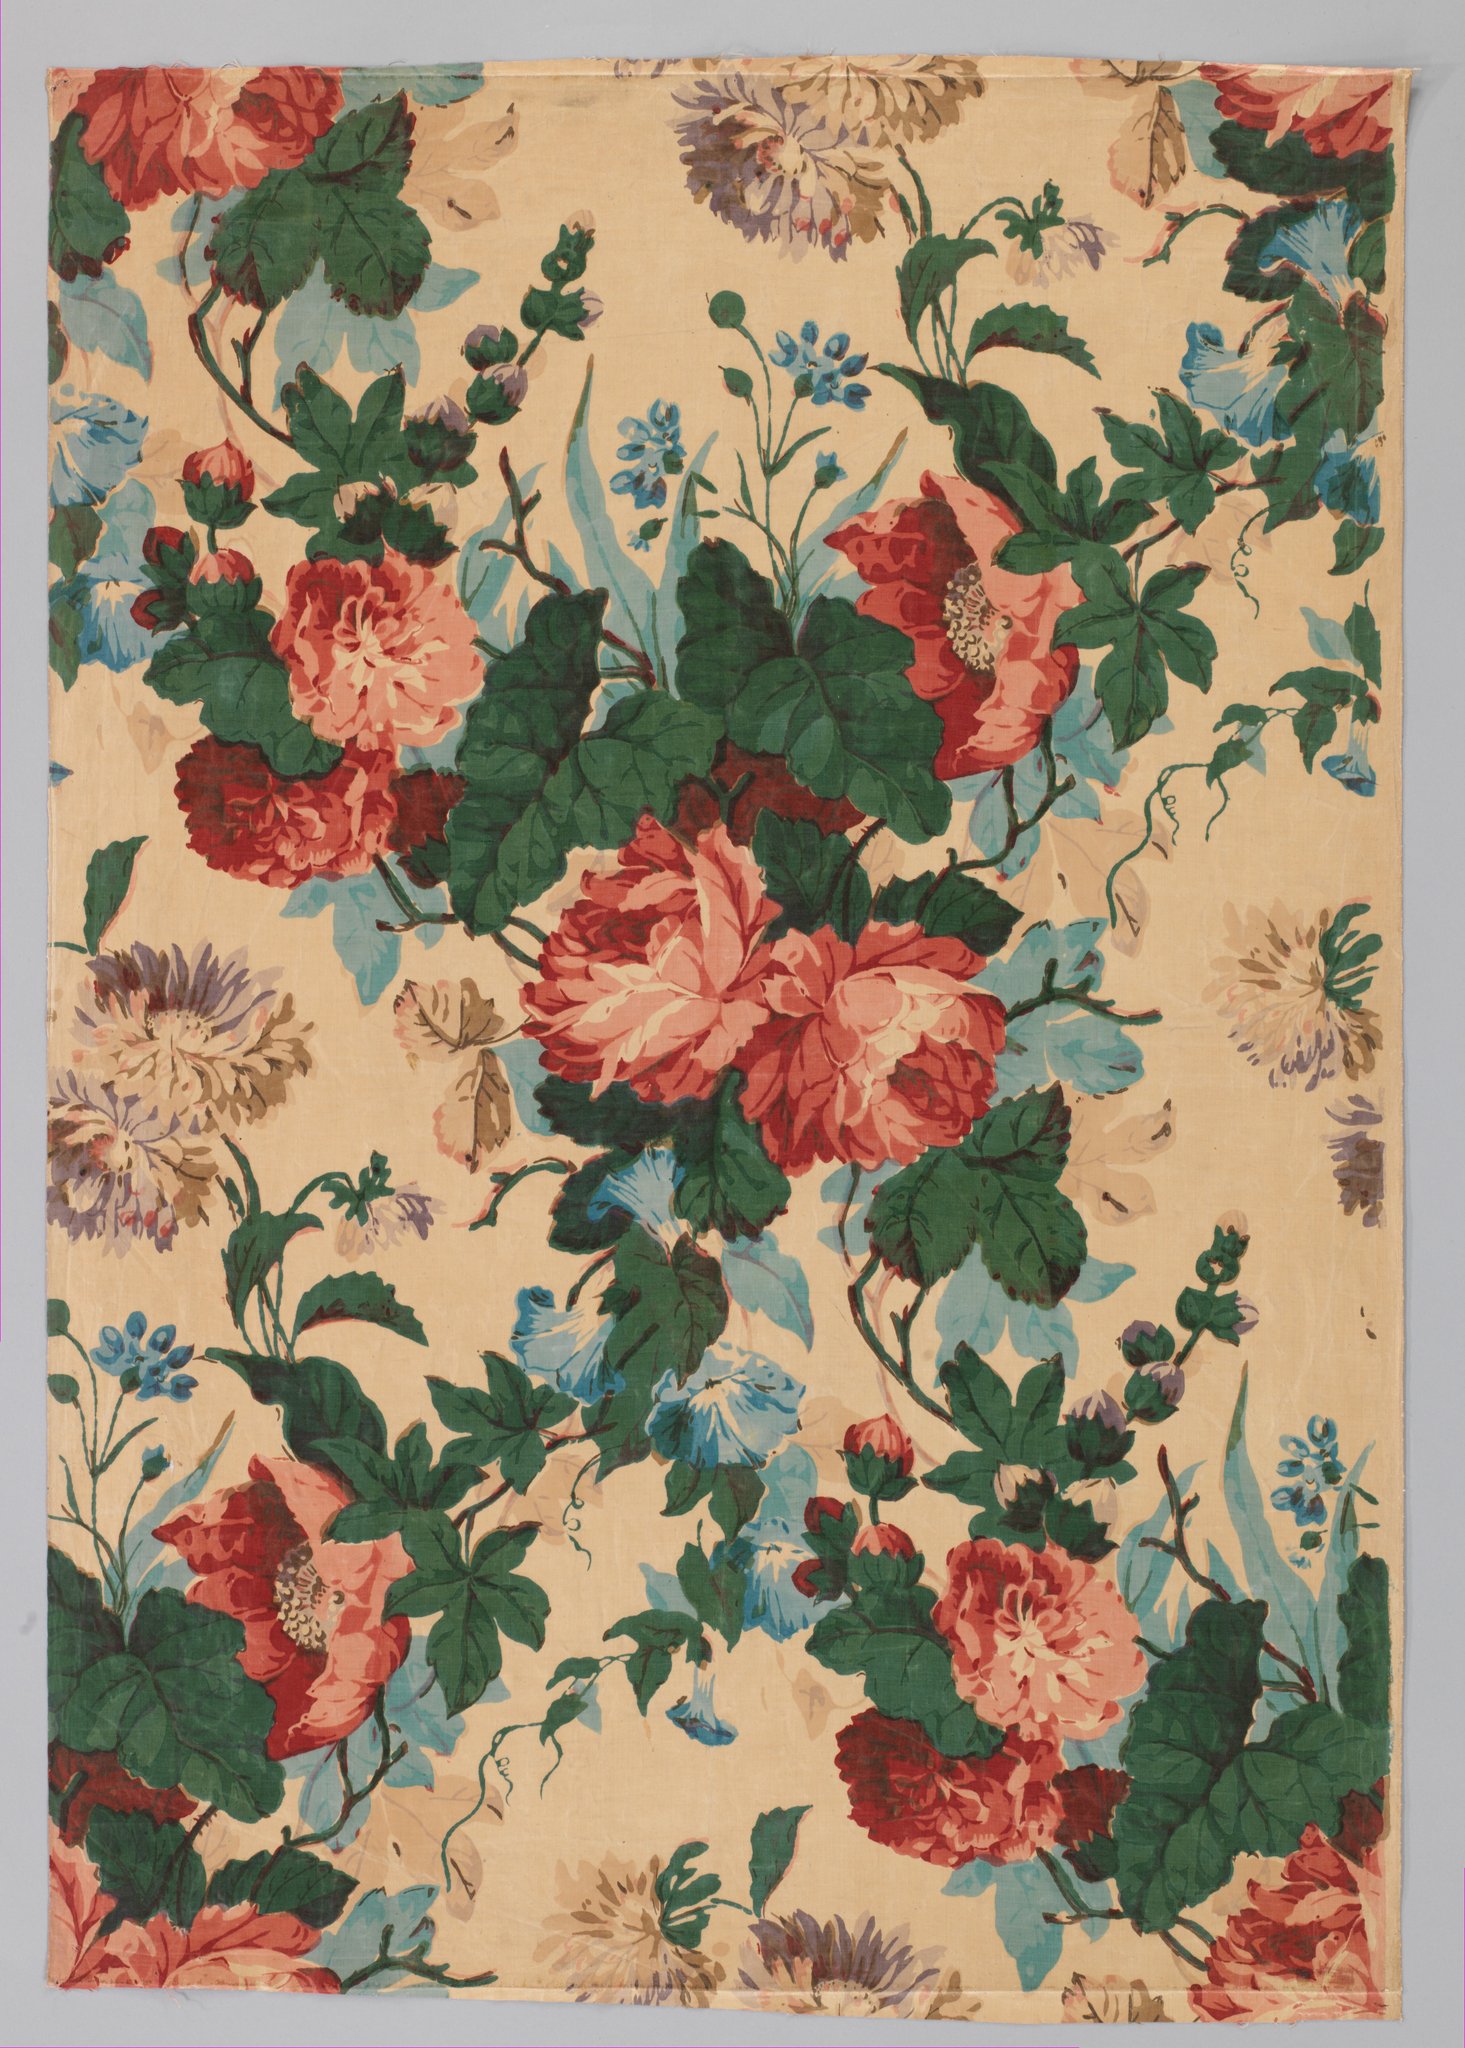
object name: piece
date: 1872-1886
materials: cotton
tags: flowers